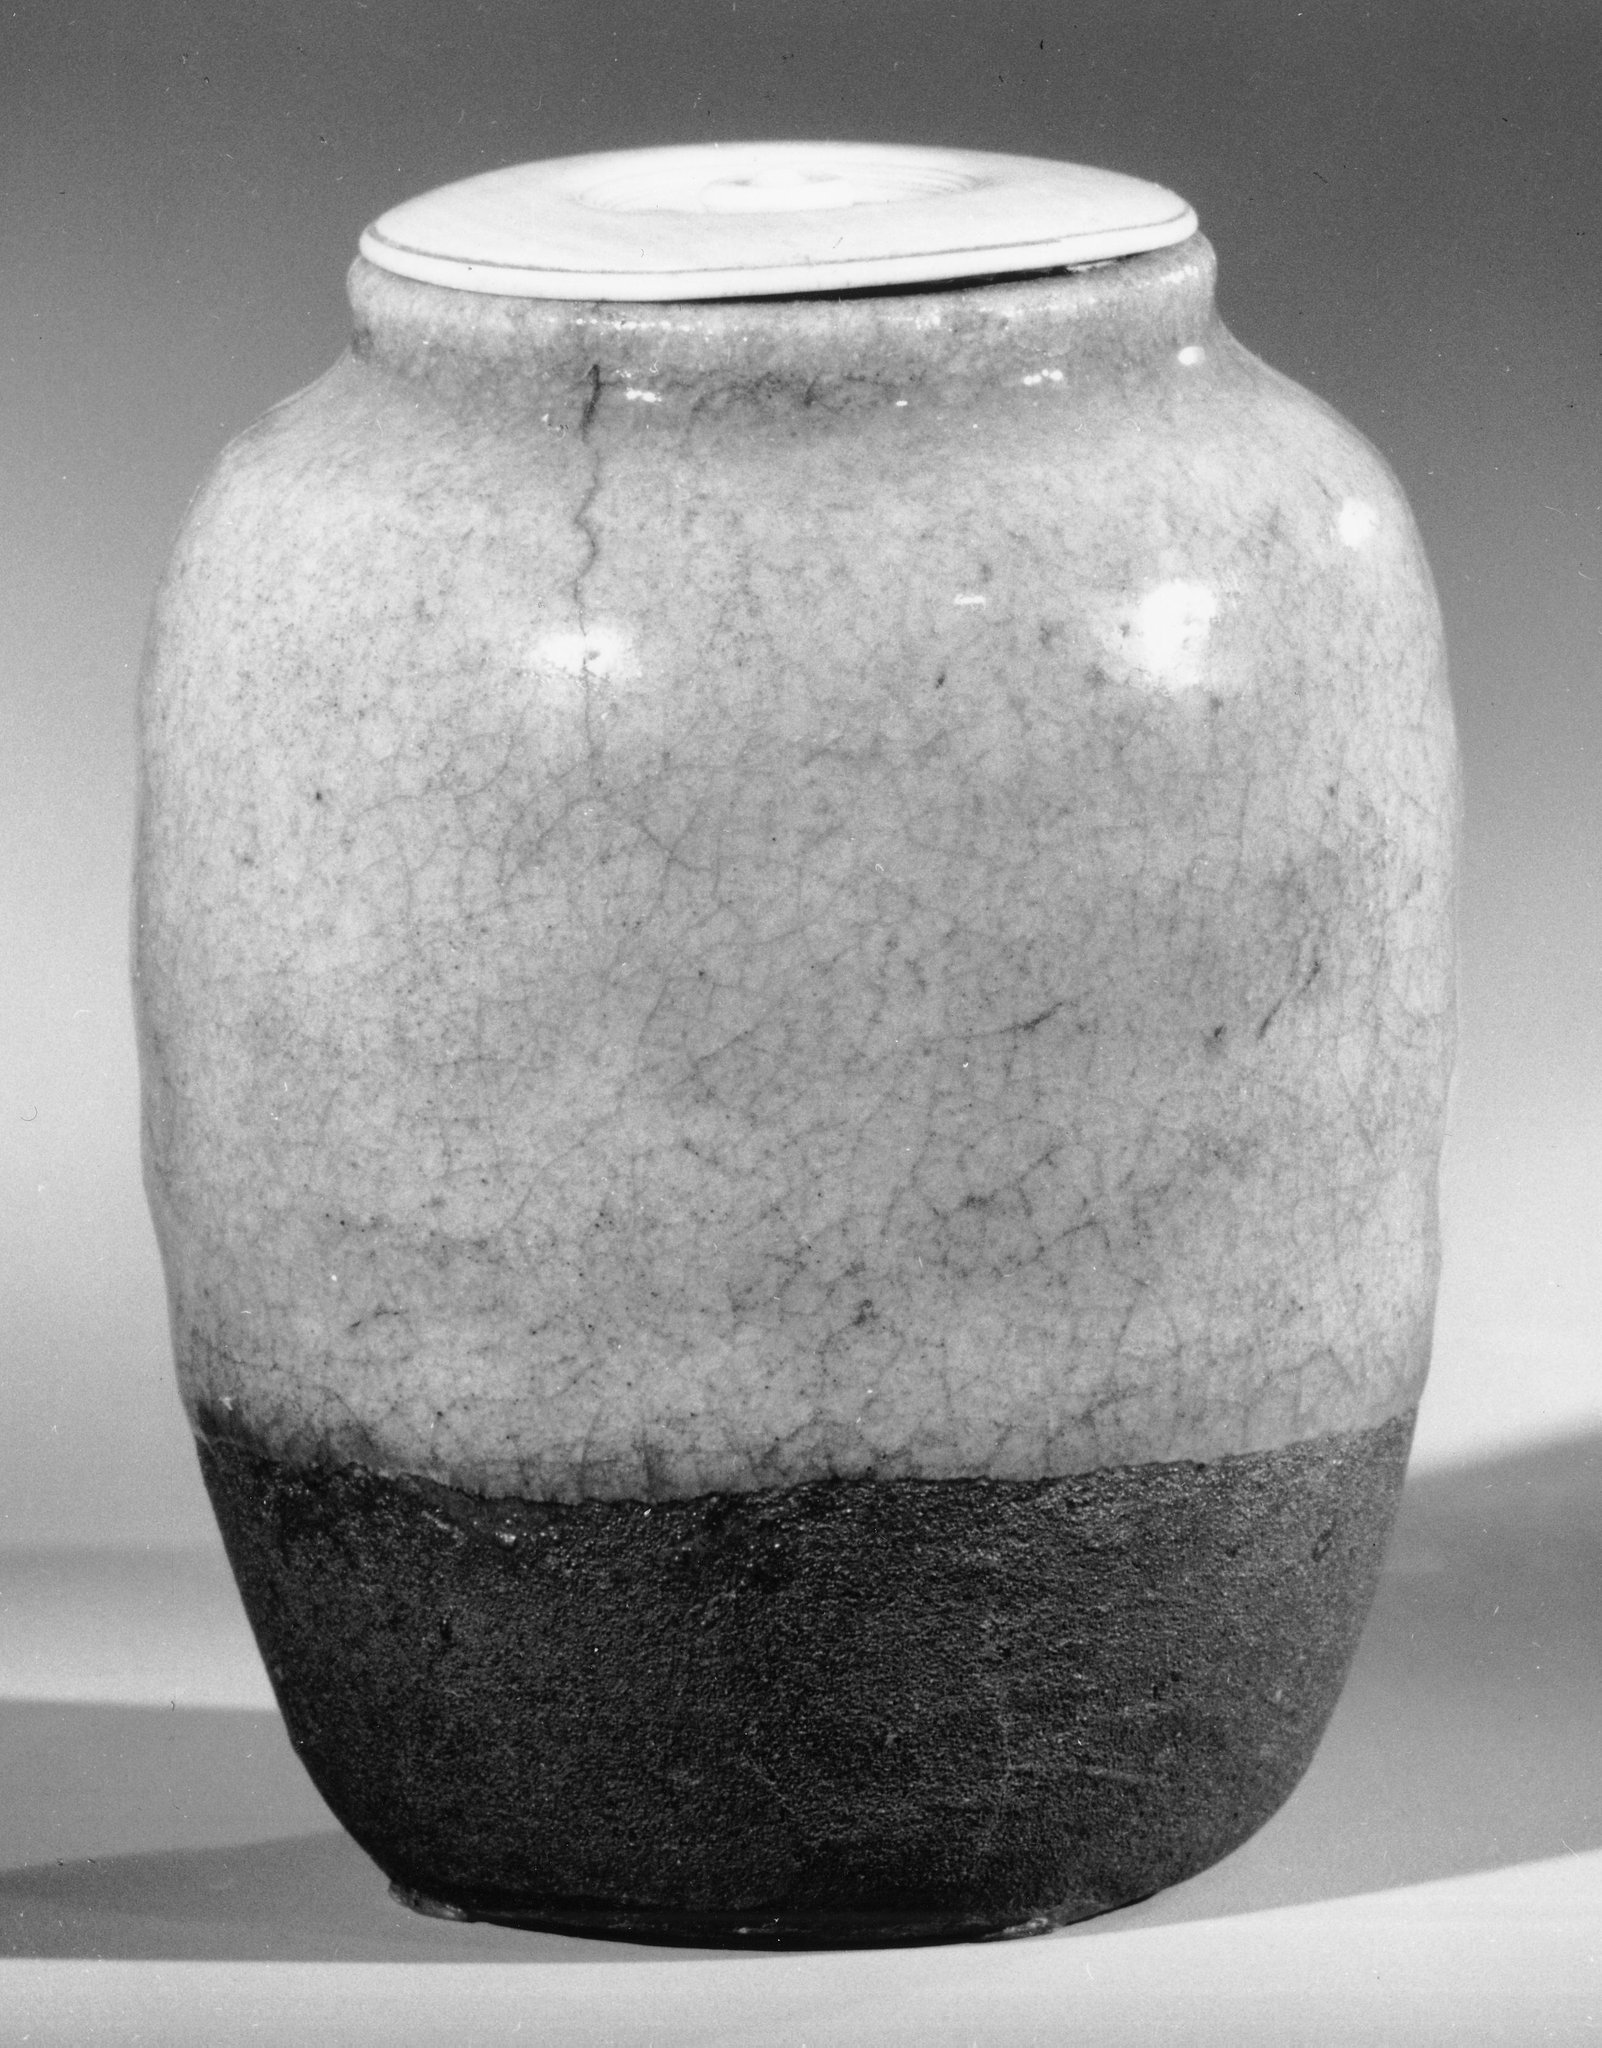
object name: tea jar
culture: japanese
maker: tôshiro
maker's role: artist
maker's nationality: japanese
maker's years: 1200-1230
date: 1245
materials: clay, glaze